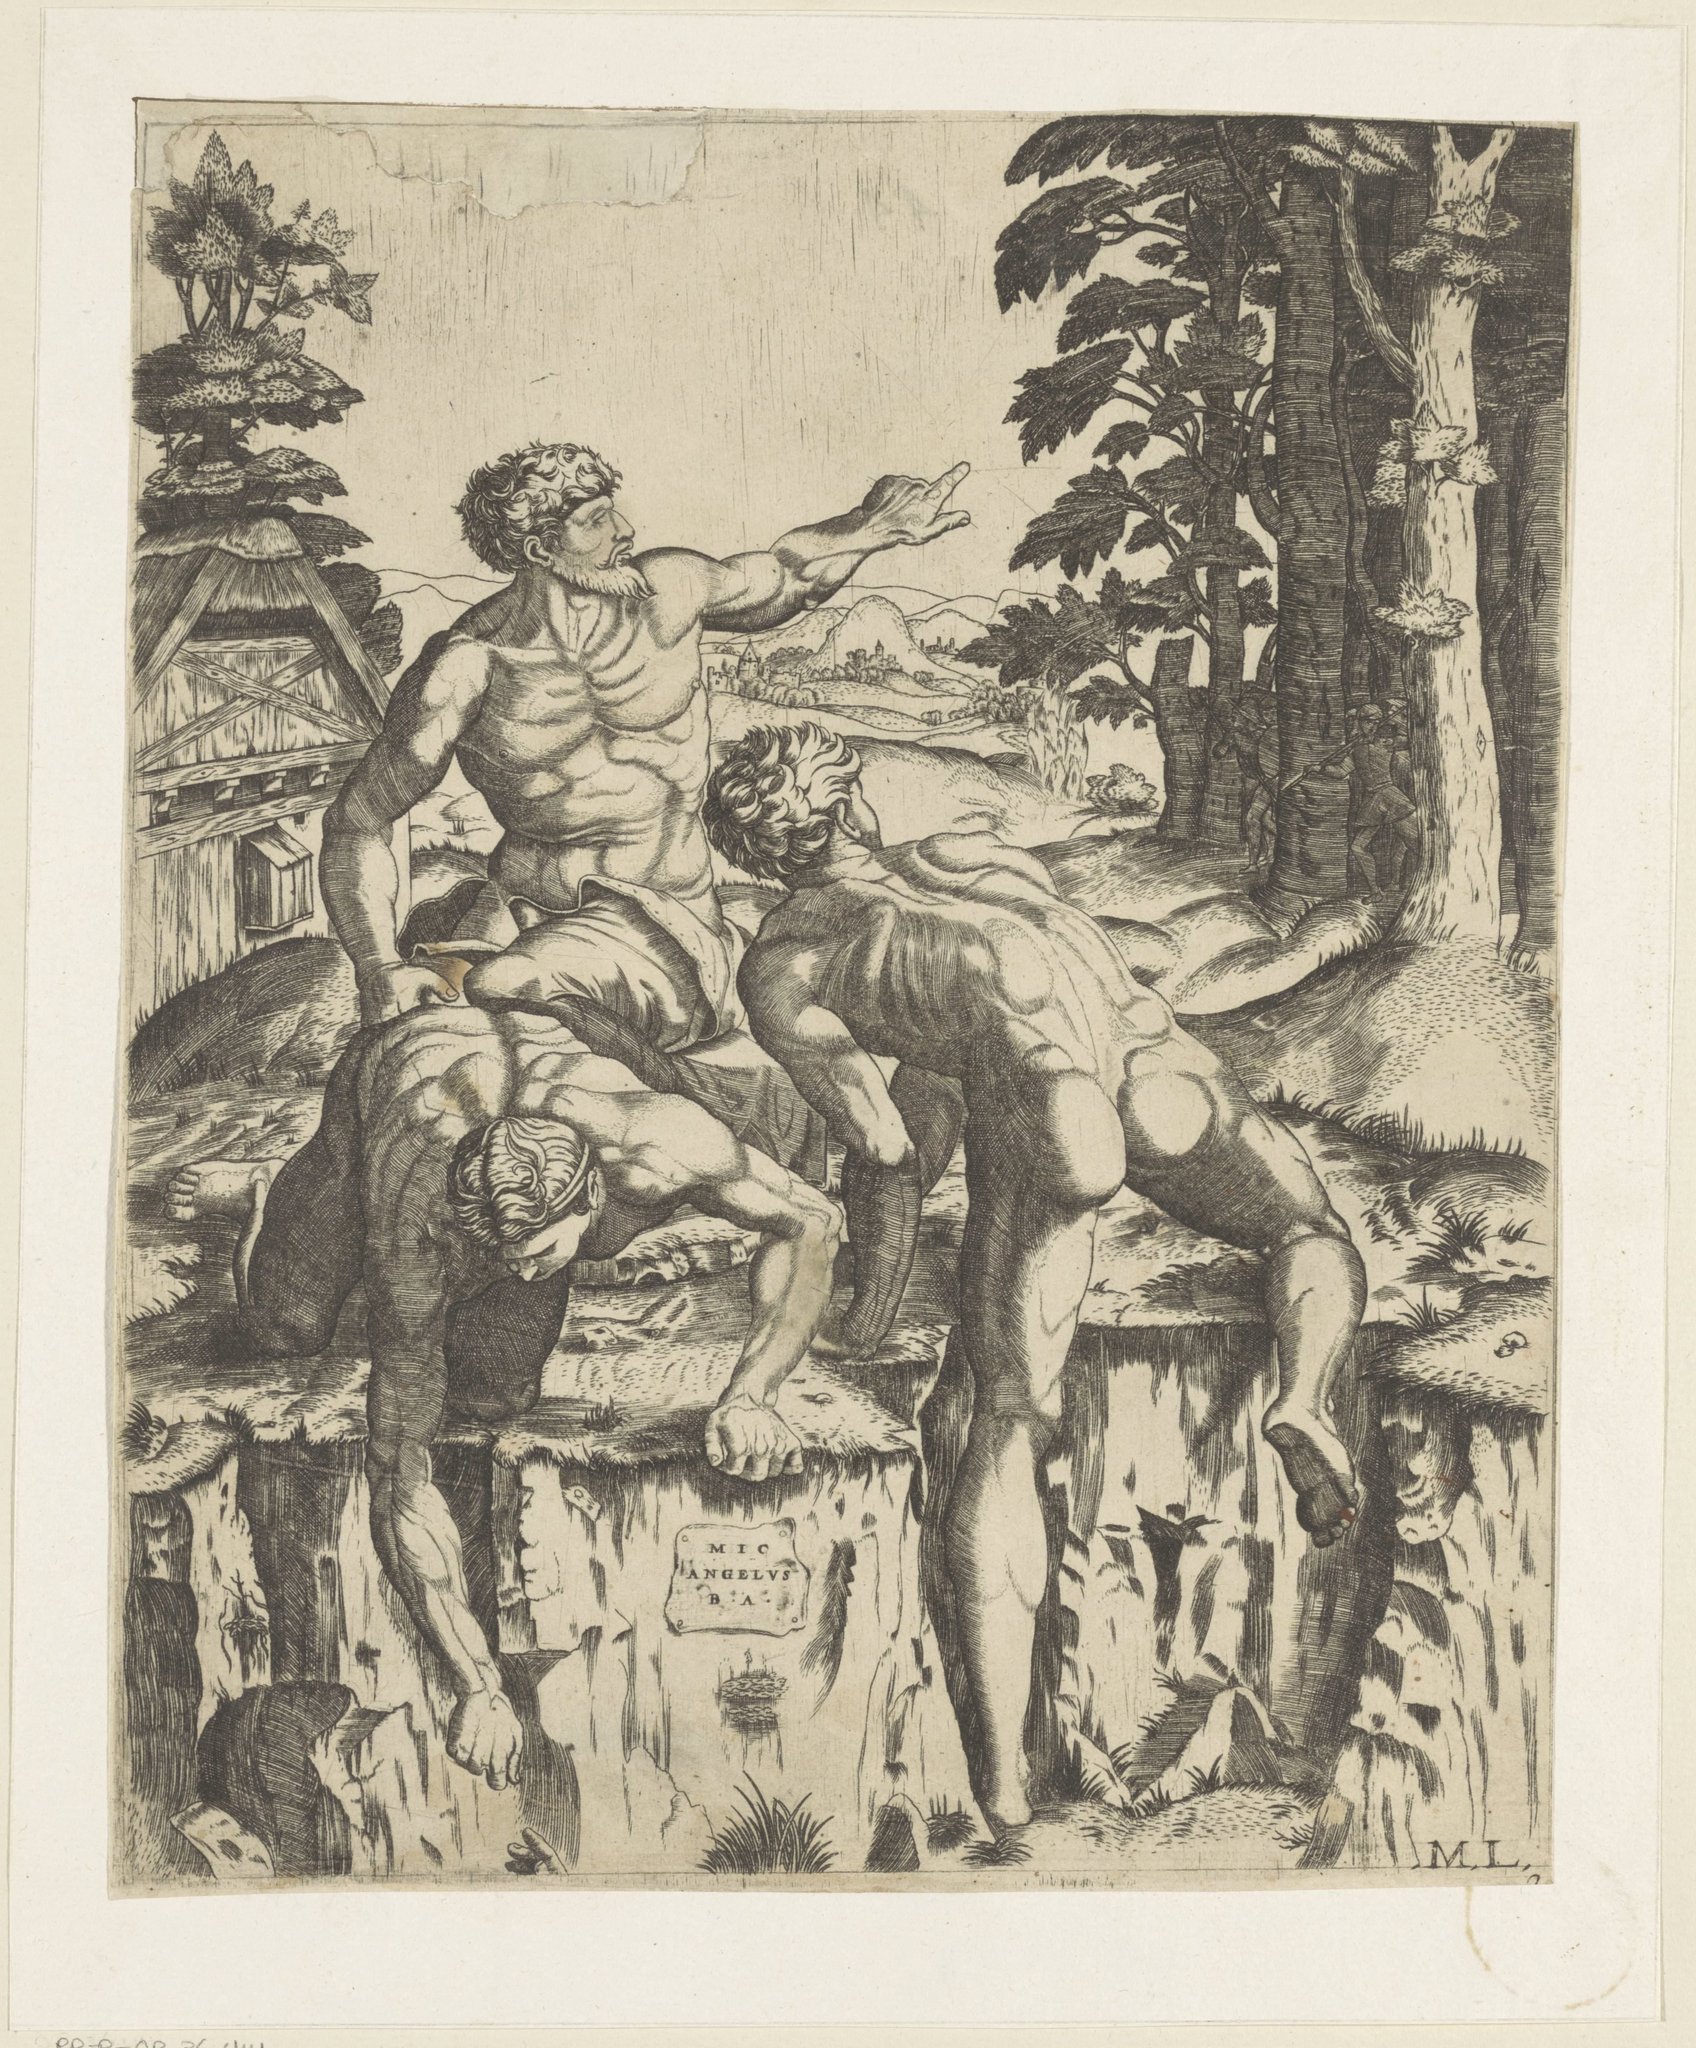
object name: print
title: Klimmers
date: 1534-1609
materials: paper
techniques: etching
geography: italy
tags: the (nude) human figure; 'corpo humano' (ripa), male sex; man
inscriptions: collector's mark: Lugt 240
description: Drie naakte mannen die zojuist een helling hebben beklommen. Een van de drie probeert een vierde figuur te helpen die nog aan het klimmen is (hand zichtbaar onder). Op de achtergrond een landschap met een schuur.